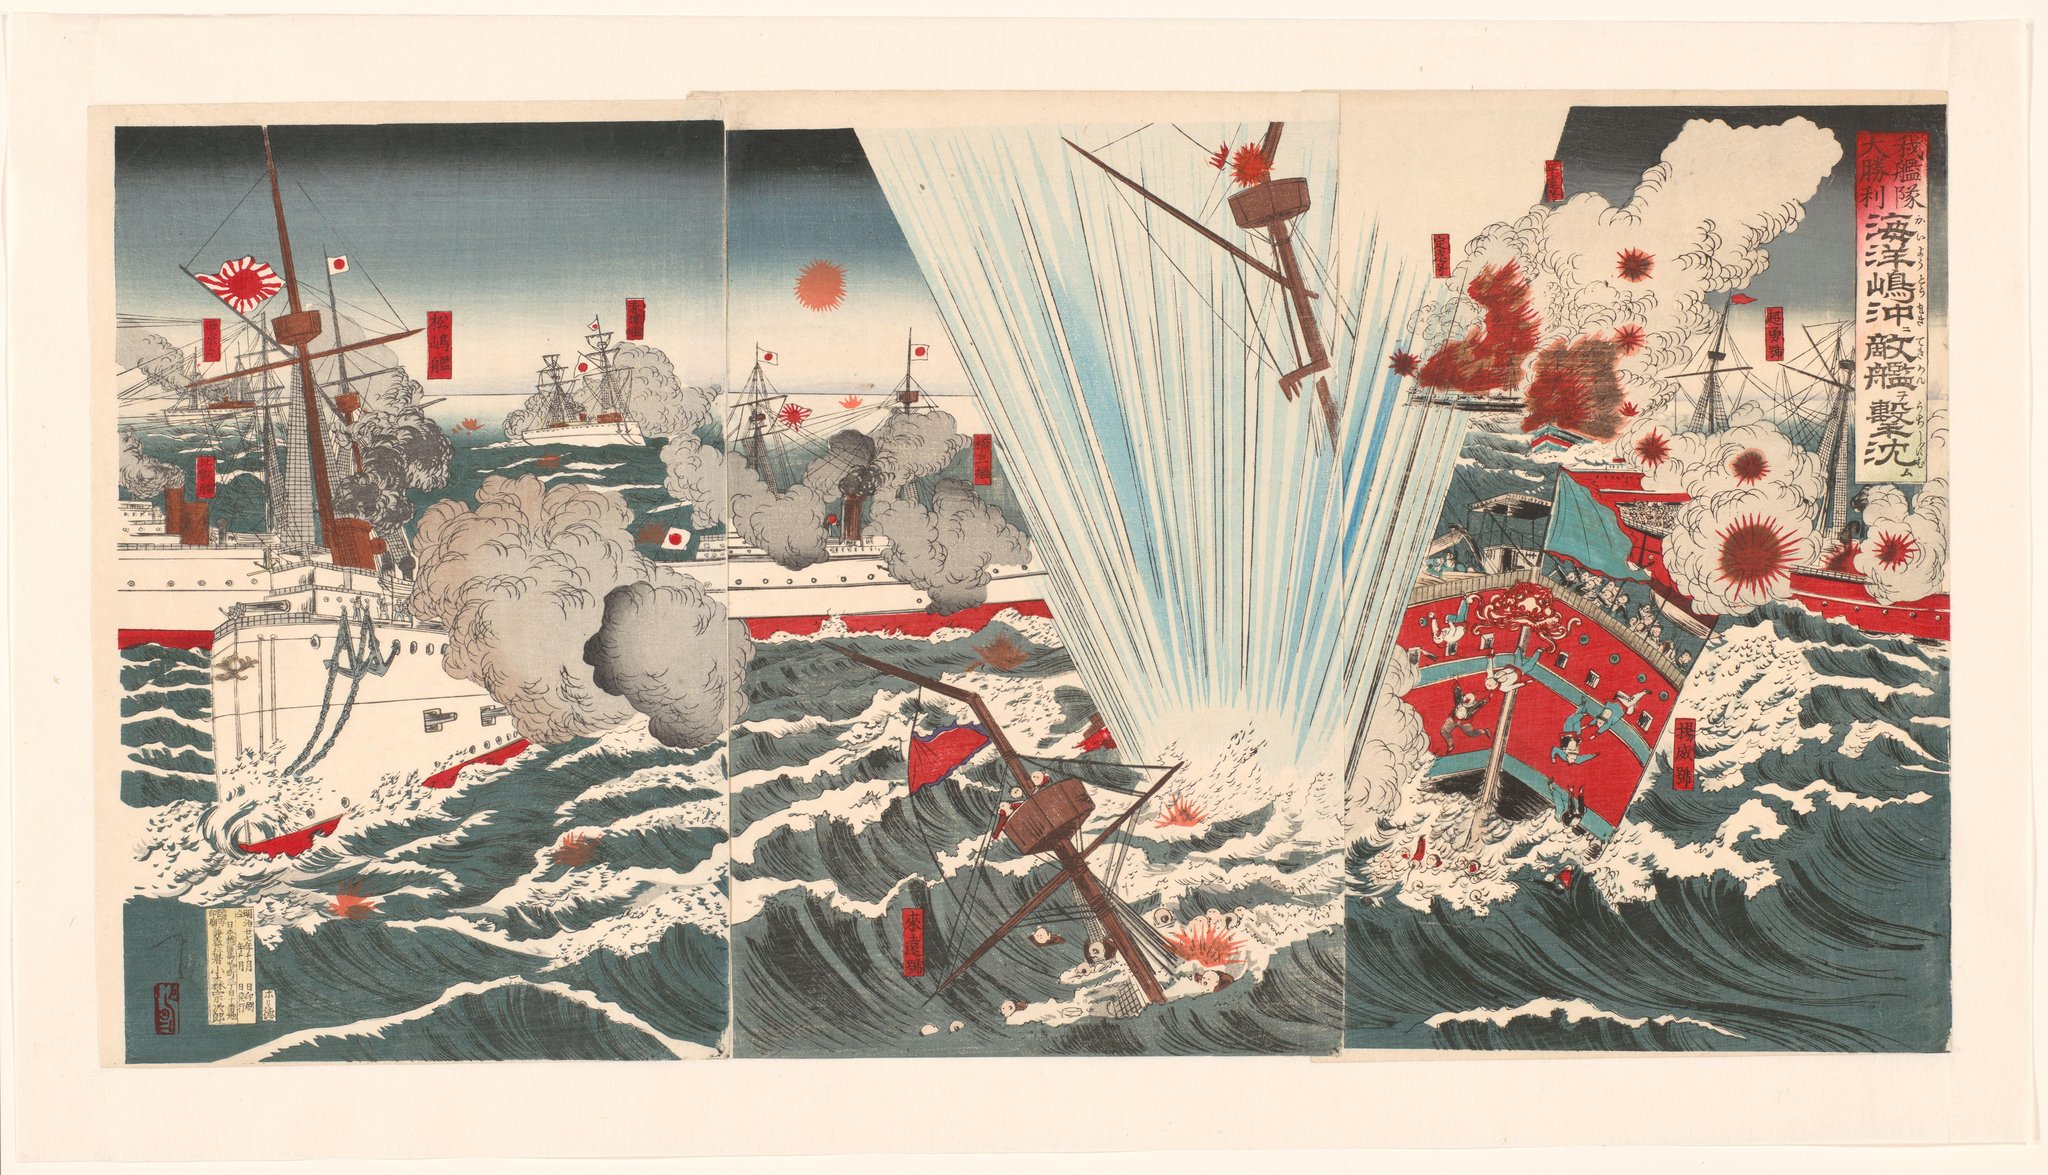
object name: print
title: Japanse oorlogsprent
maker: Anonymous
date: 1894-1905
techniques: woodcut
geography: japan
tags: war